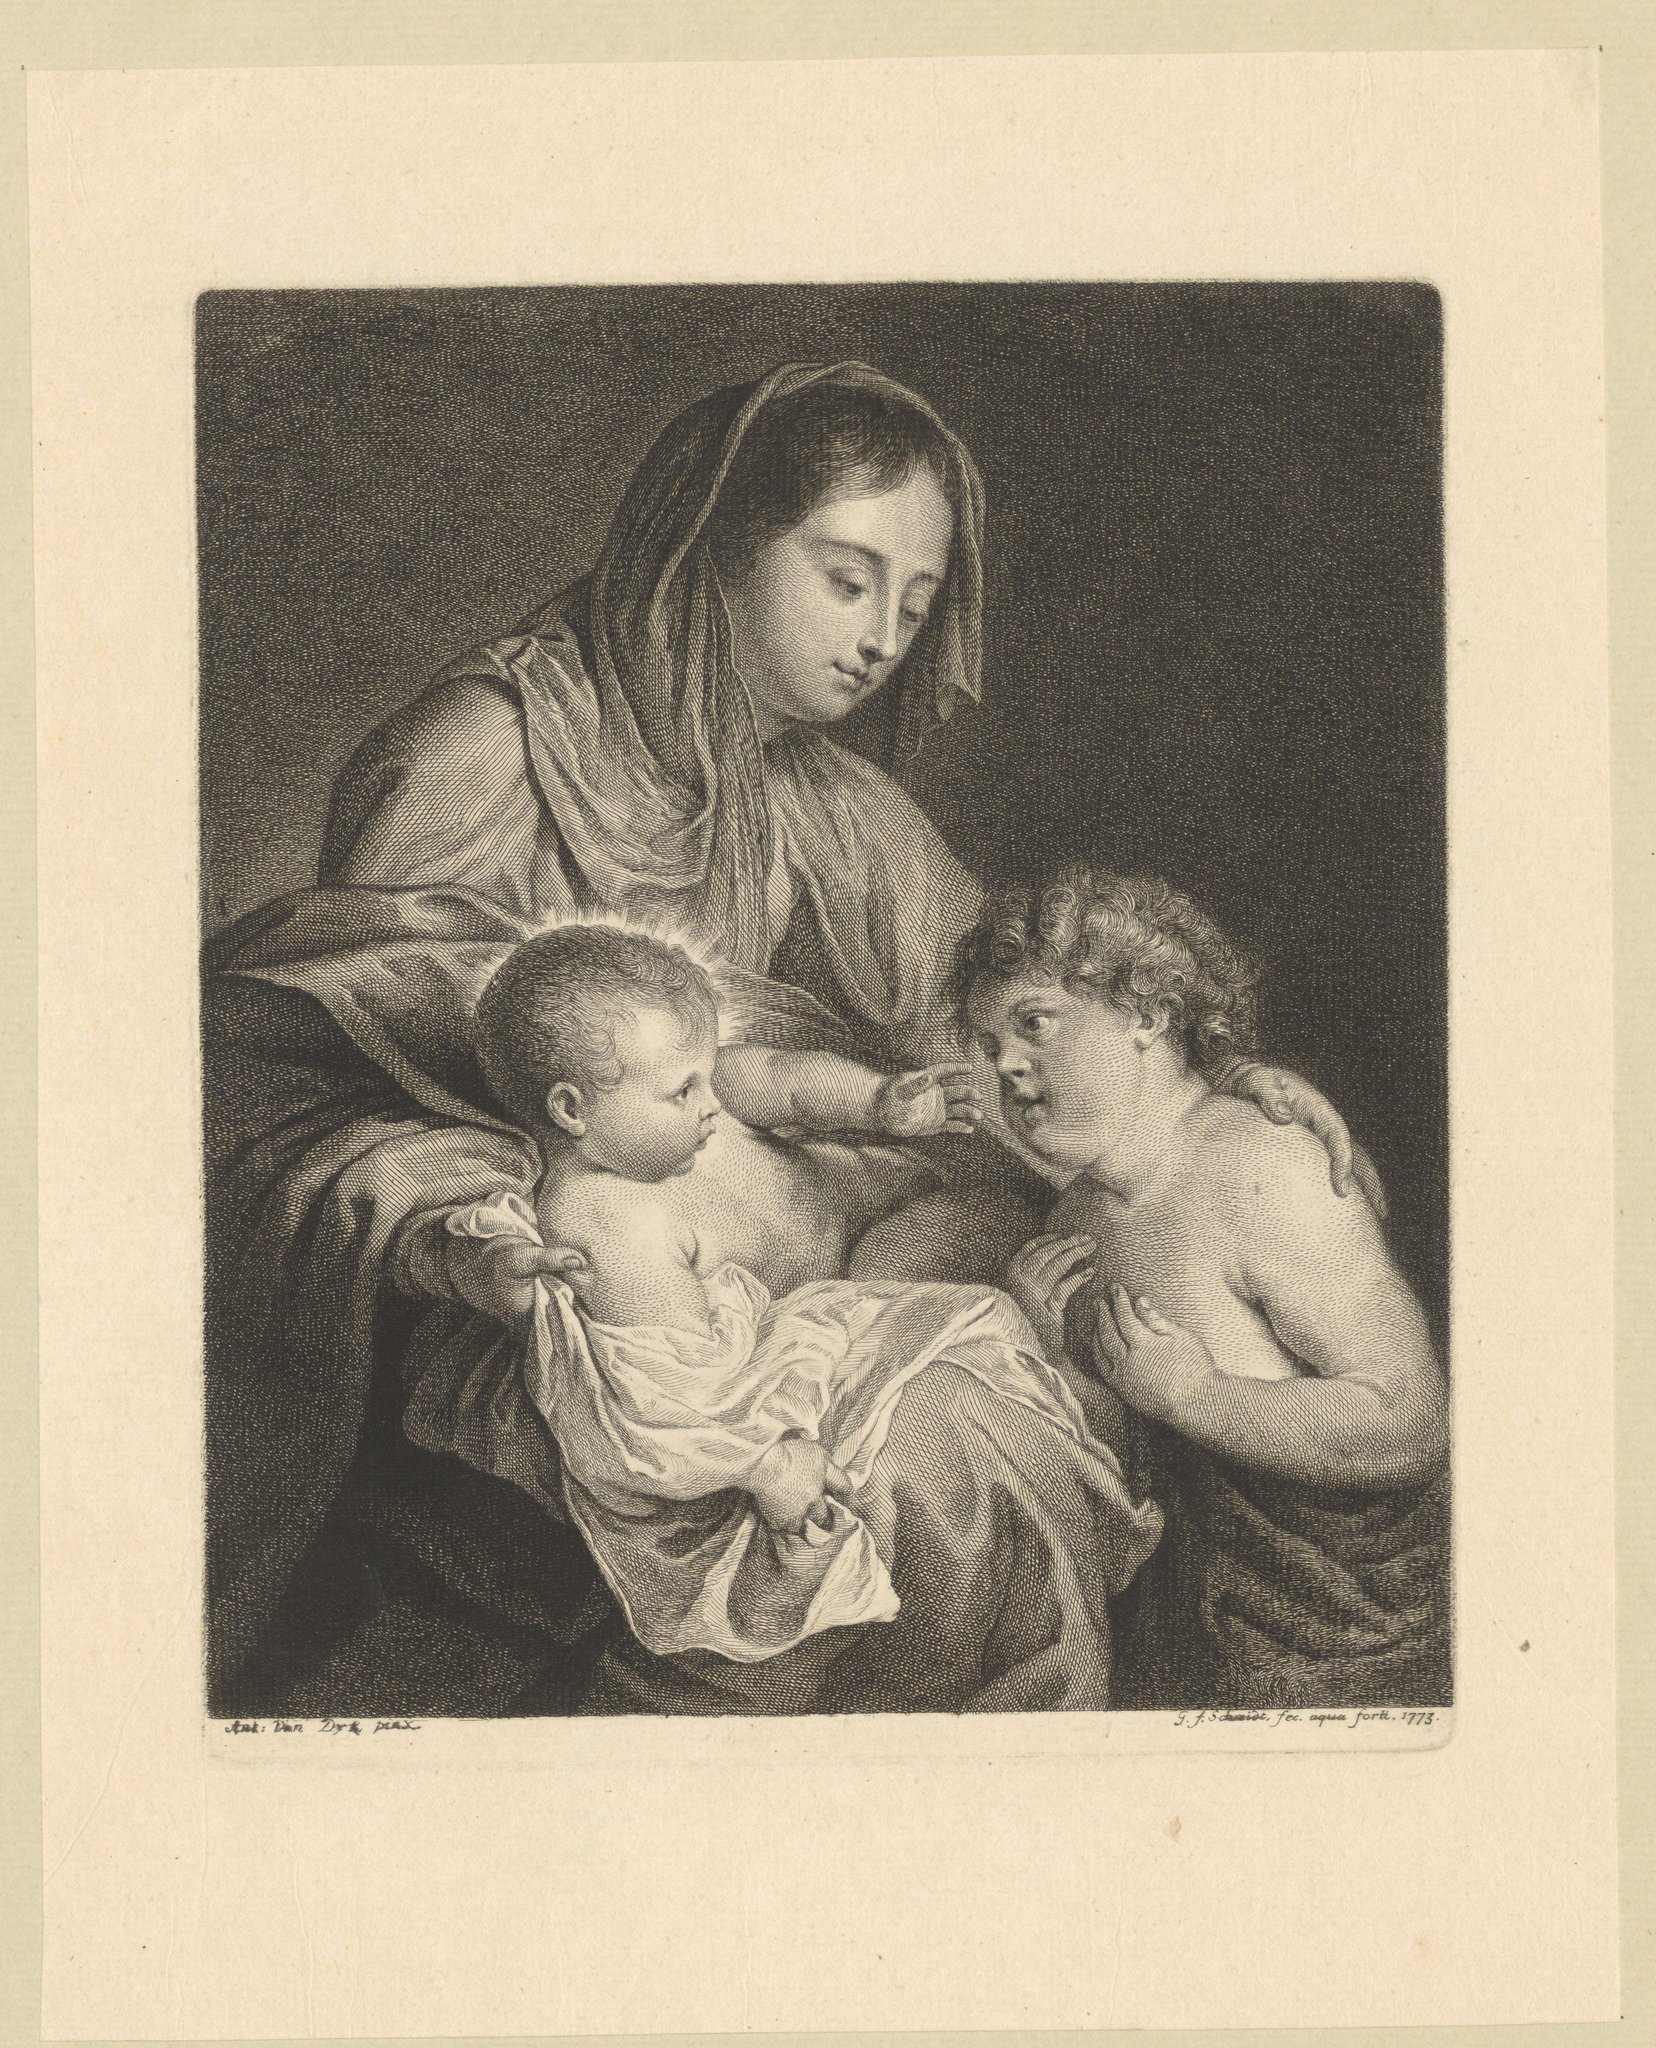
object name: print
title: Madonna met kind en Johannes de Doper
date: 1773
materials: paper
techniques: etching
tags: 'regina coeli', 'regina angelorum', 'maestà', john the baptist present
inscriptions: collector's mark: Lugt 240